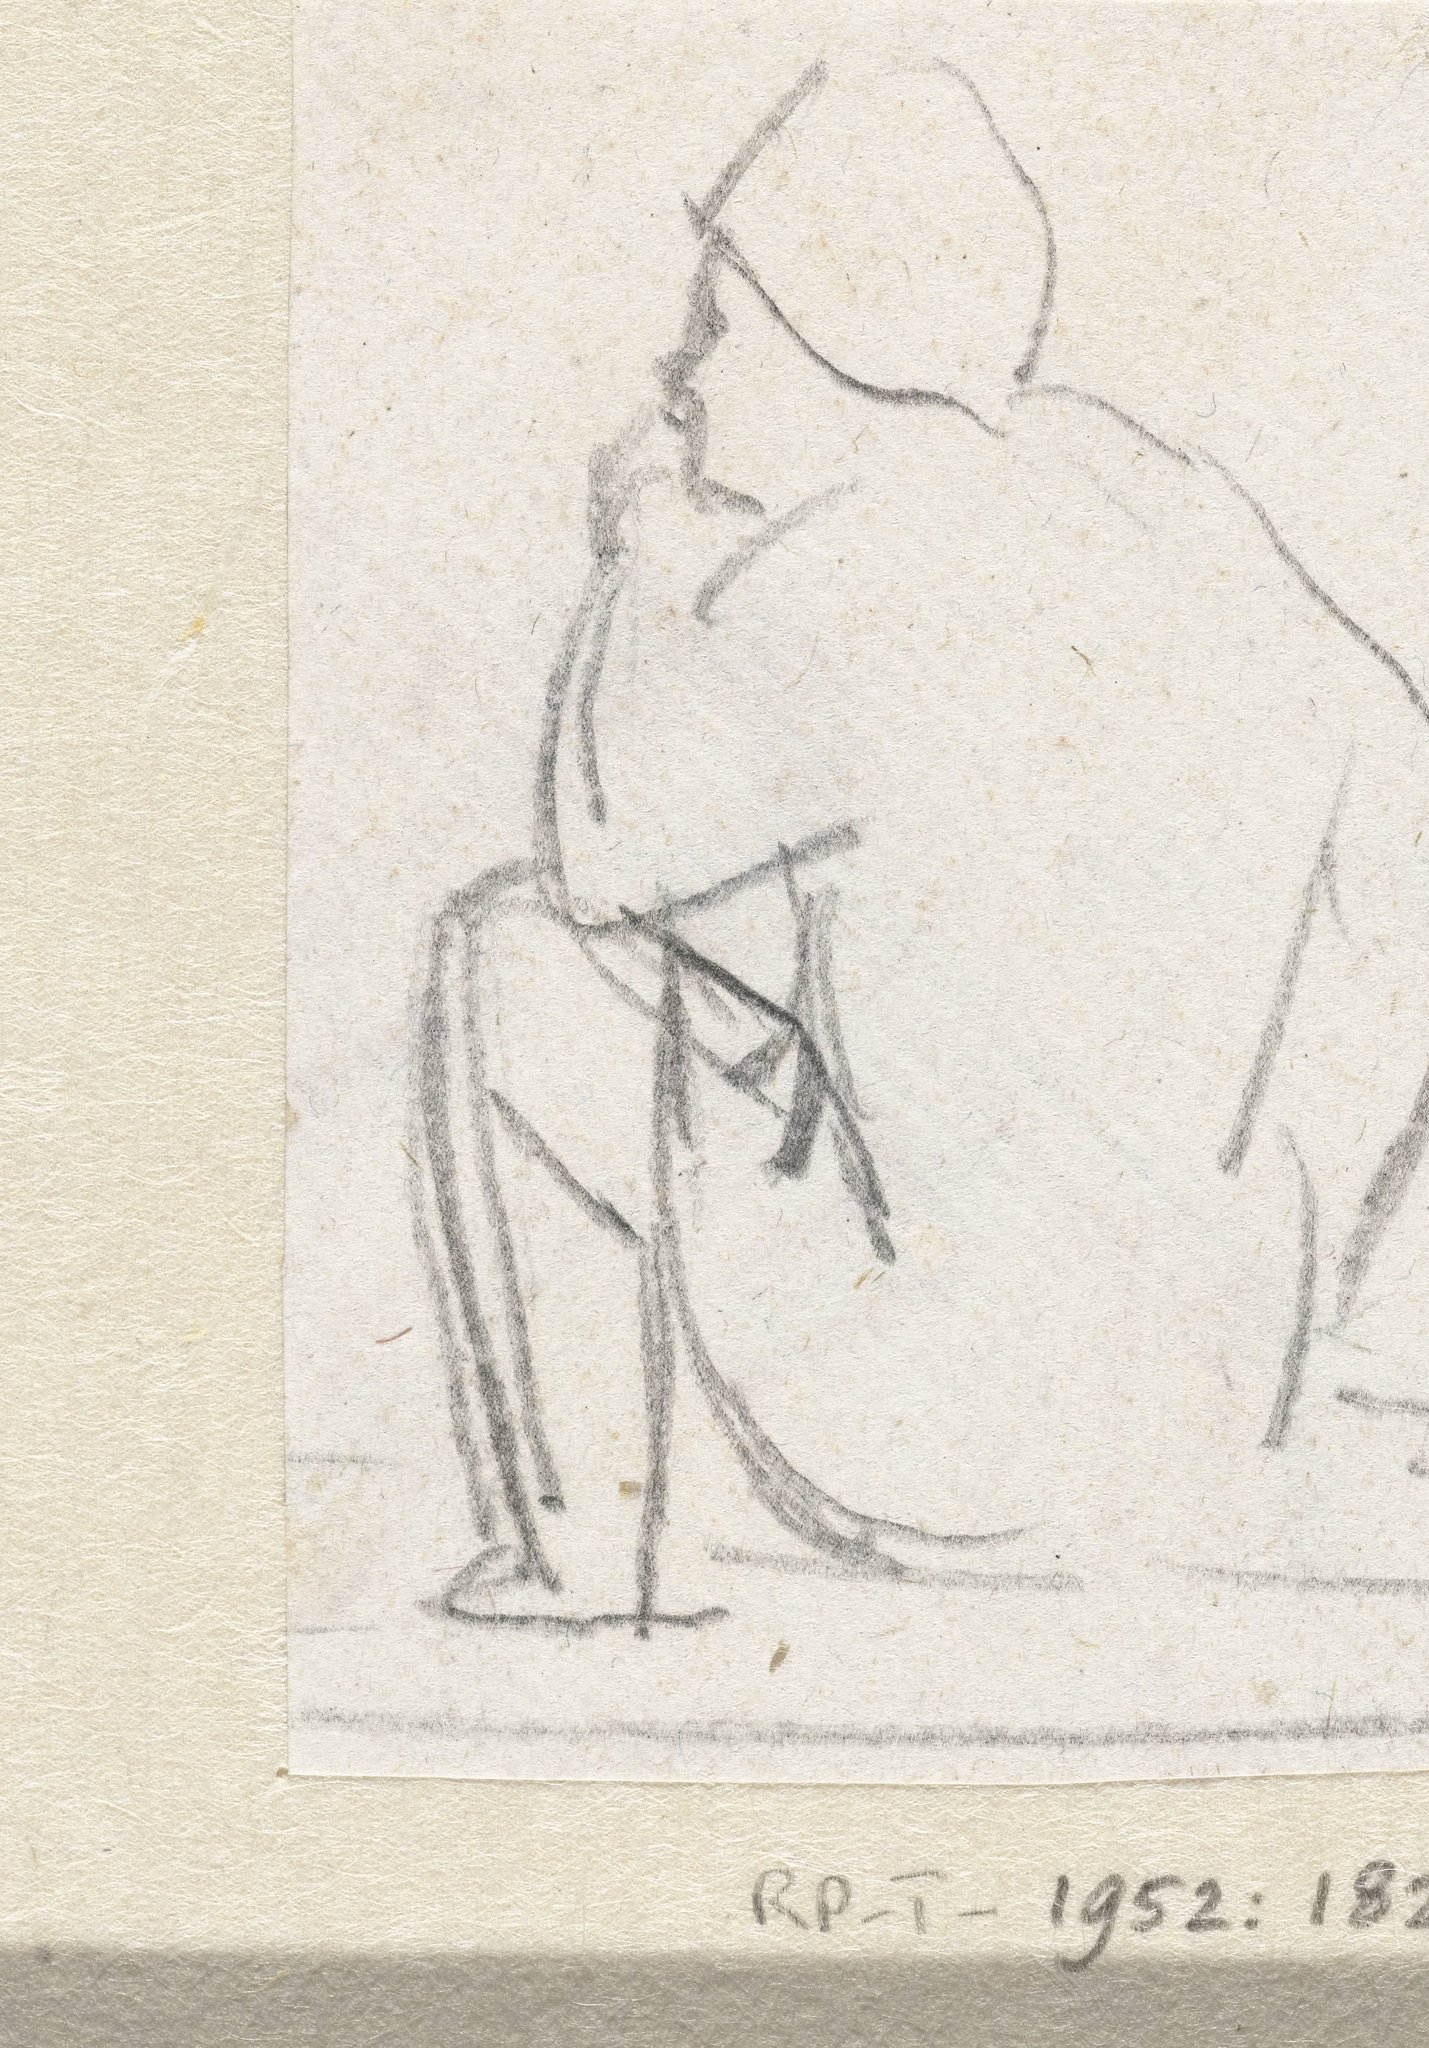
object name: drawing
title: Schets van een zittende man, op de rug gezien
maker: simon andreas krausz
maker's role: draughtsman, print maker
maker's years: 1760-1825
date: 1770-1825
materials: paper, pencil